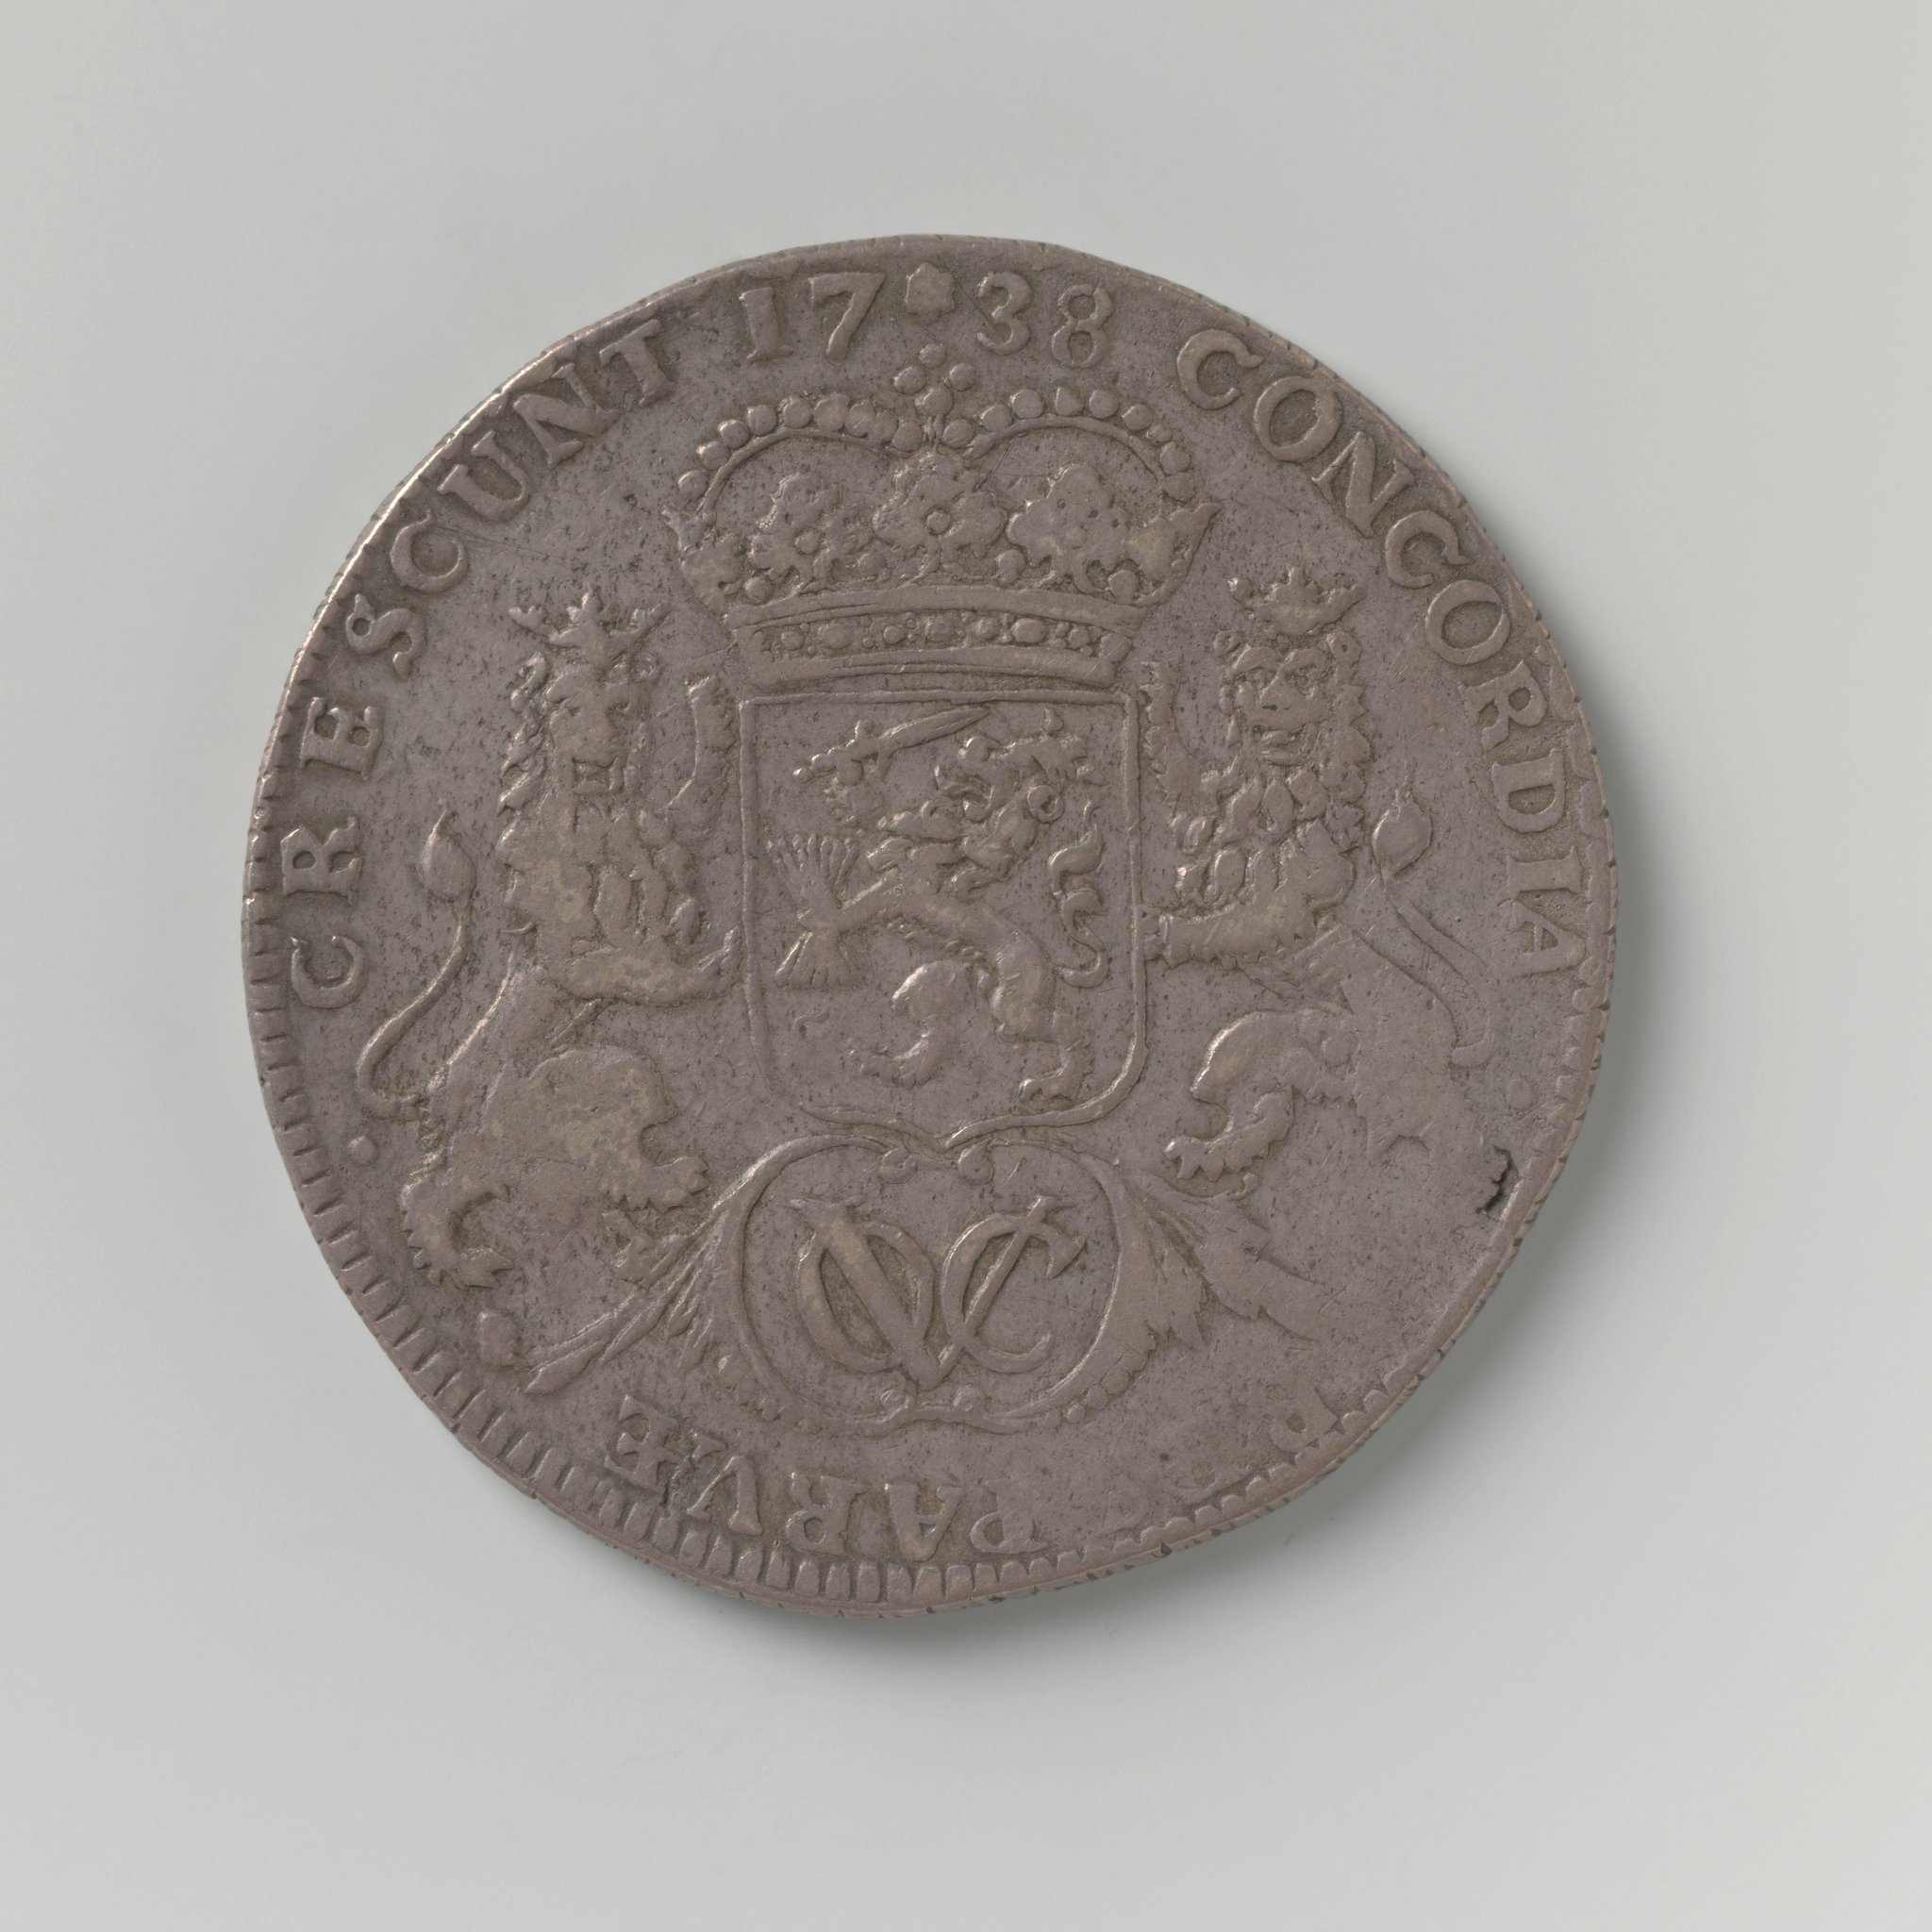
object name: coin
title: Zilveren rijder van de VOC uit Gelderland, 1738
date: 1738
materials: silver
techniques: striking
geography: harderwijk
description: Zilveren munt. Voorzijde: geharnaste ridder met zwaard te paard naar rechts, waaronder gekroond wapenschild van Gelderland. Keerzijde: gekroond generaliteitswapenschild, waaronder cartouche, waarin monogram van de VOC. Jaartal in omschrift, boven kroon. Gladde rand. Op voorzijde toetsmerk.